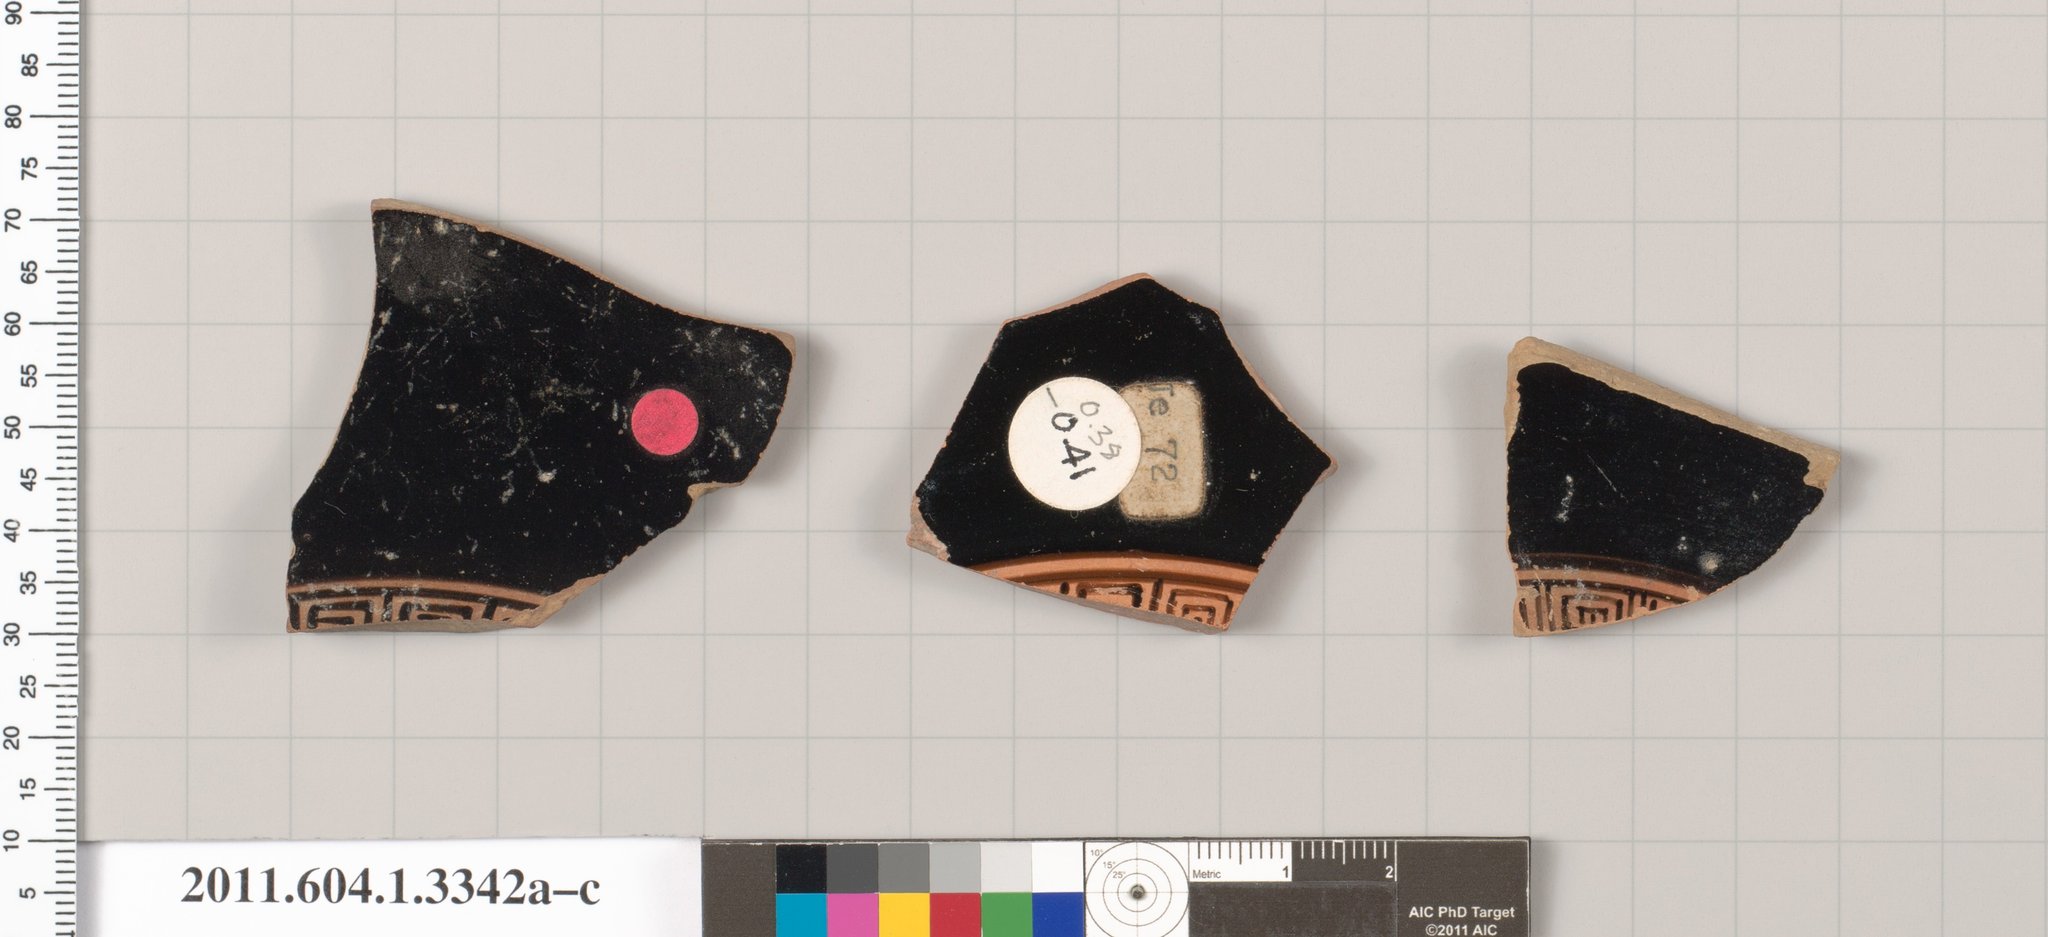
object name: kylix fragment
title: Terracotta fragments of kylikes (drinking cups)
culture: greek, attic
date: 500-470 BCE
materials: terracotta